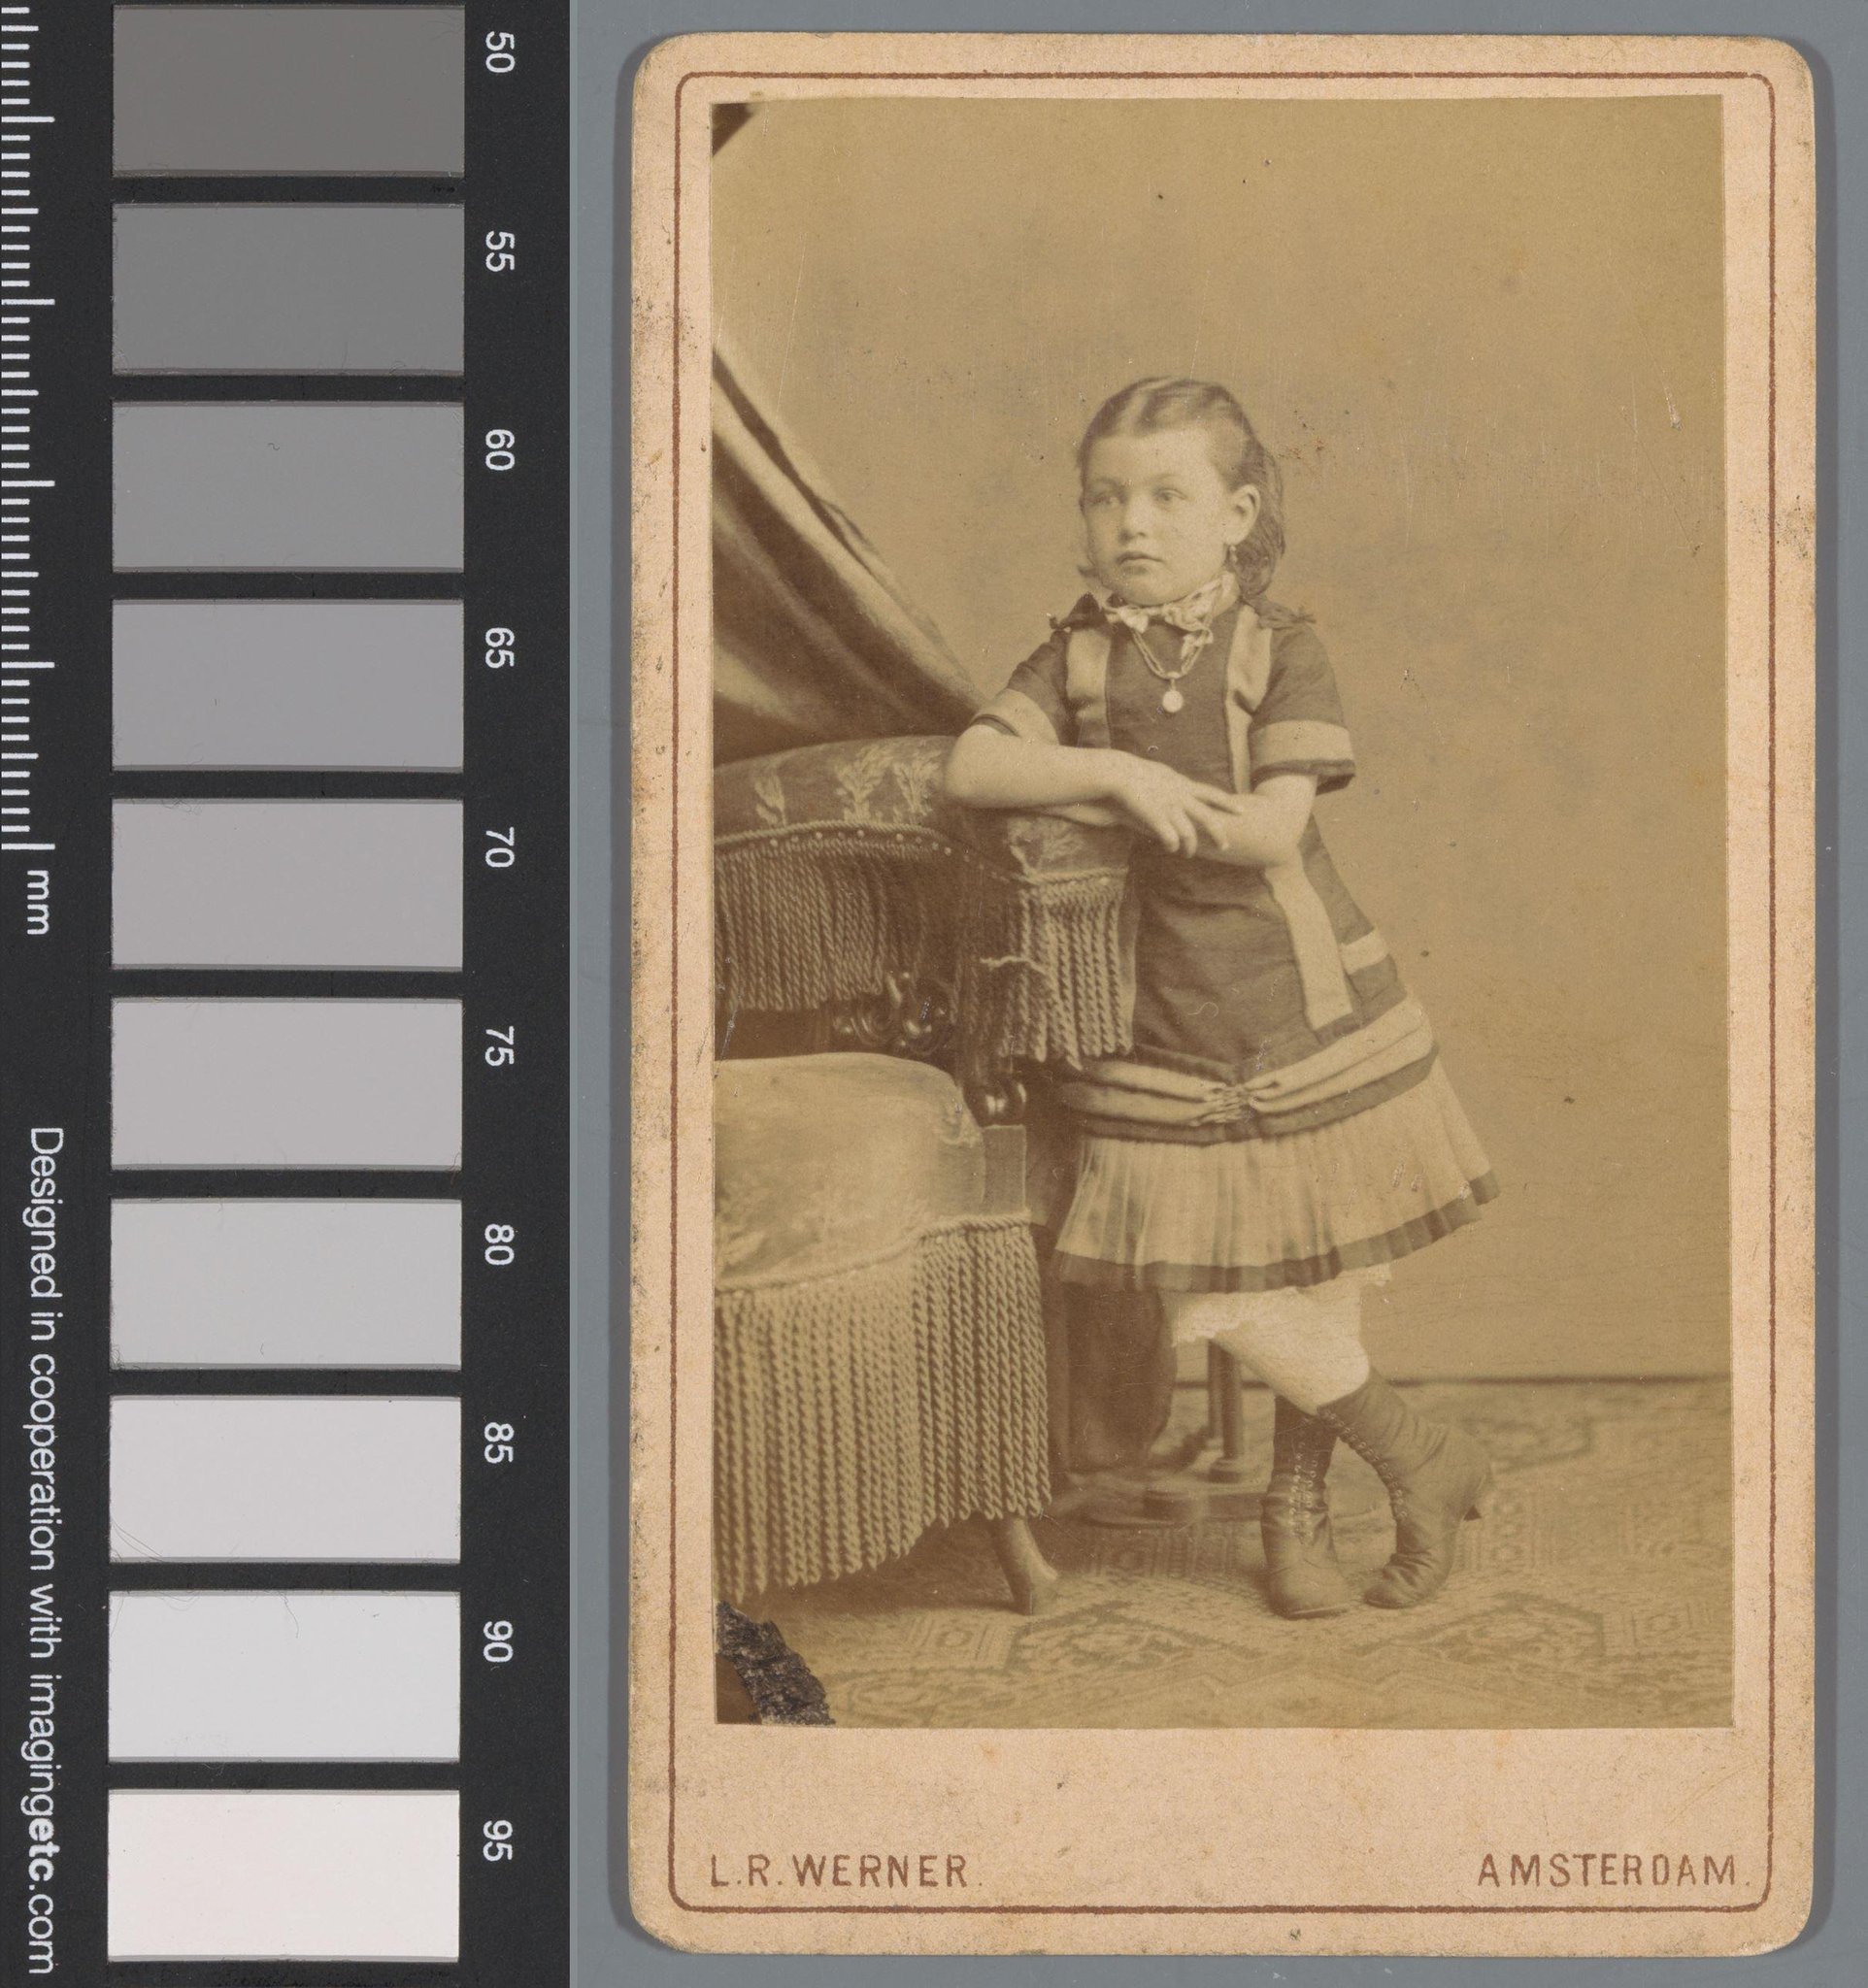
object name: carte de visite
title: Portret van een onbekend meisje naast een fauteuil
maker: louis robert werner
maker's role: fotograaf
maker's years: 1834-1896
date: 1878-1886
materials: cardboard, paper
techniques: albumen print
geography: amsterdam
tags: girl (child between toddler and youth), anonymous historical person portrayed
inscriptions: address: ‘Nieuwendyk H. 150./ AMSTERDAM’, inscription: ‘vorheen/ P. Carstensen./ Voor nabestellingen blijft de Plaat bewaard.’